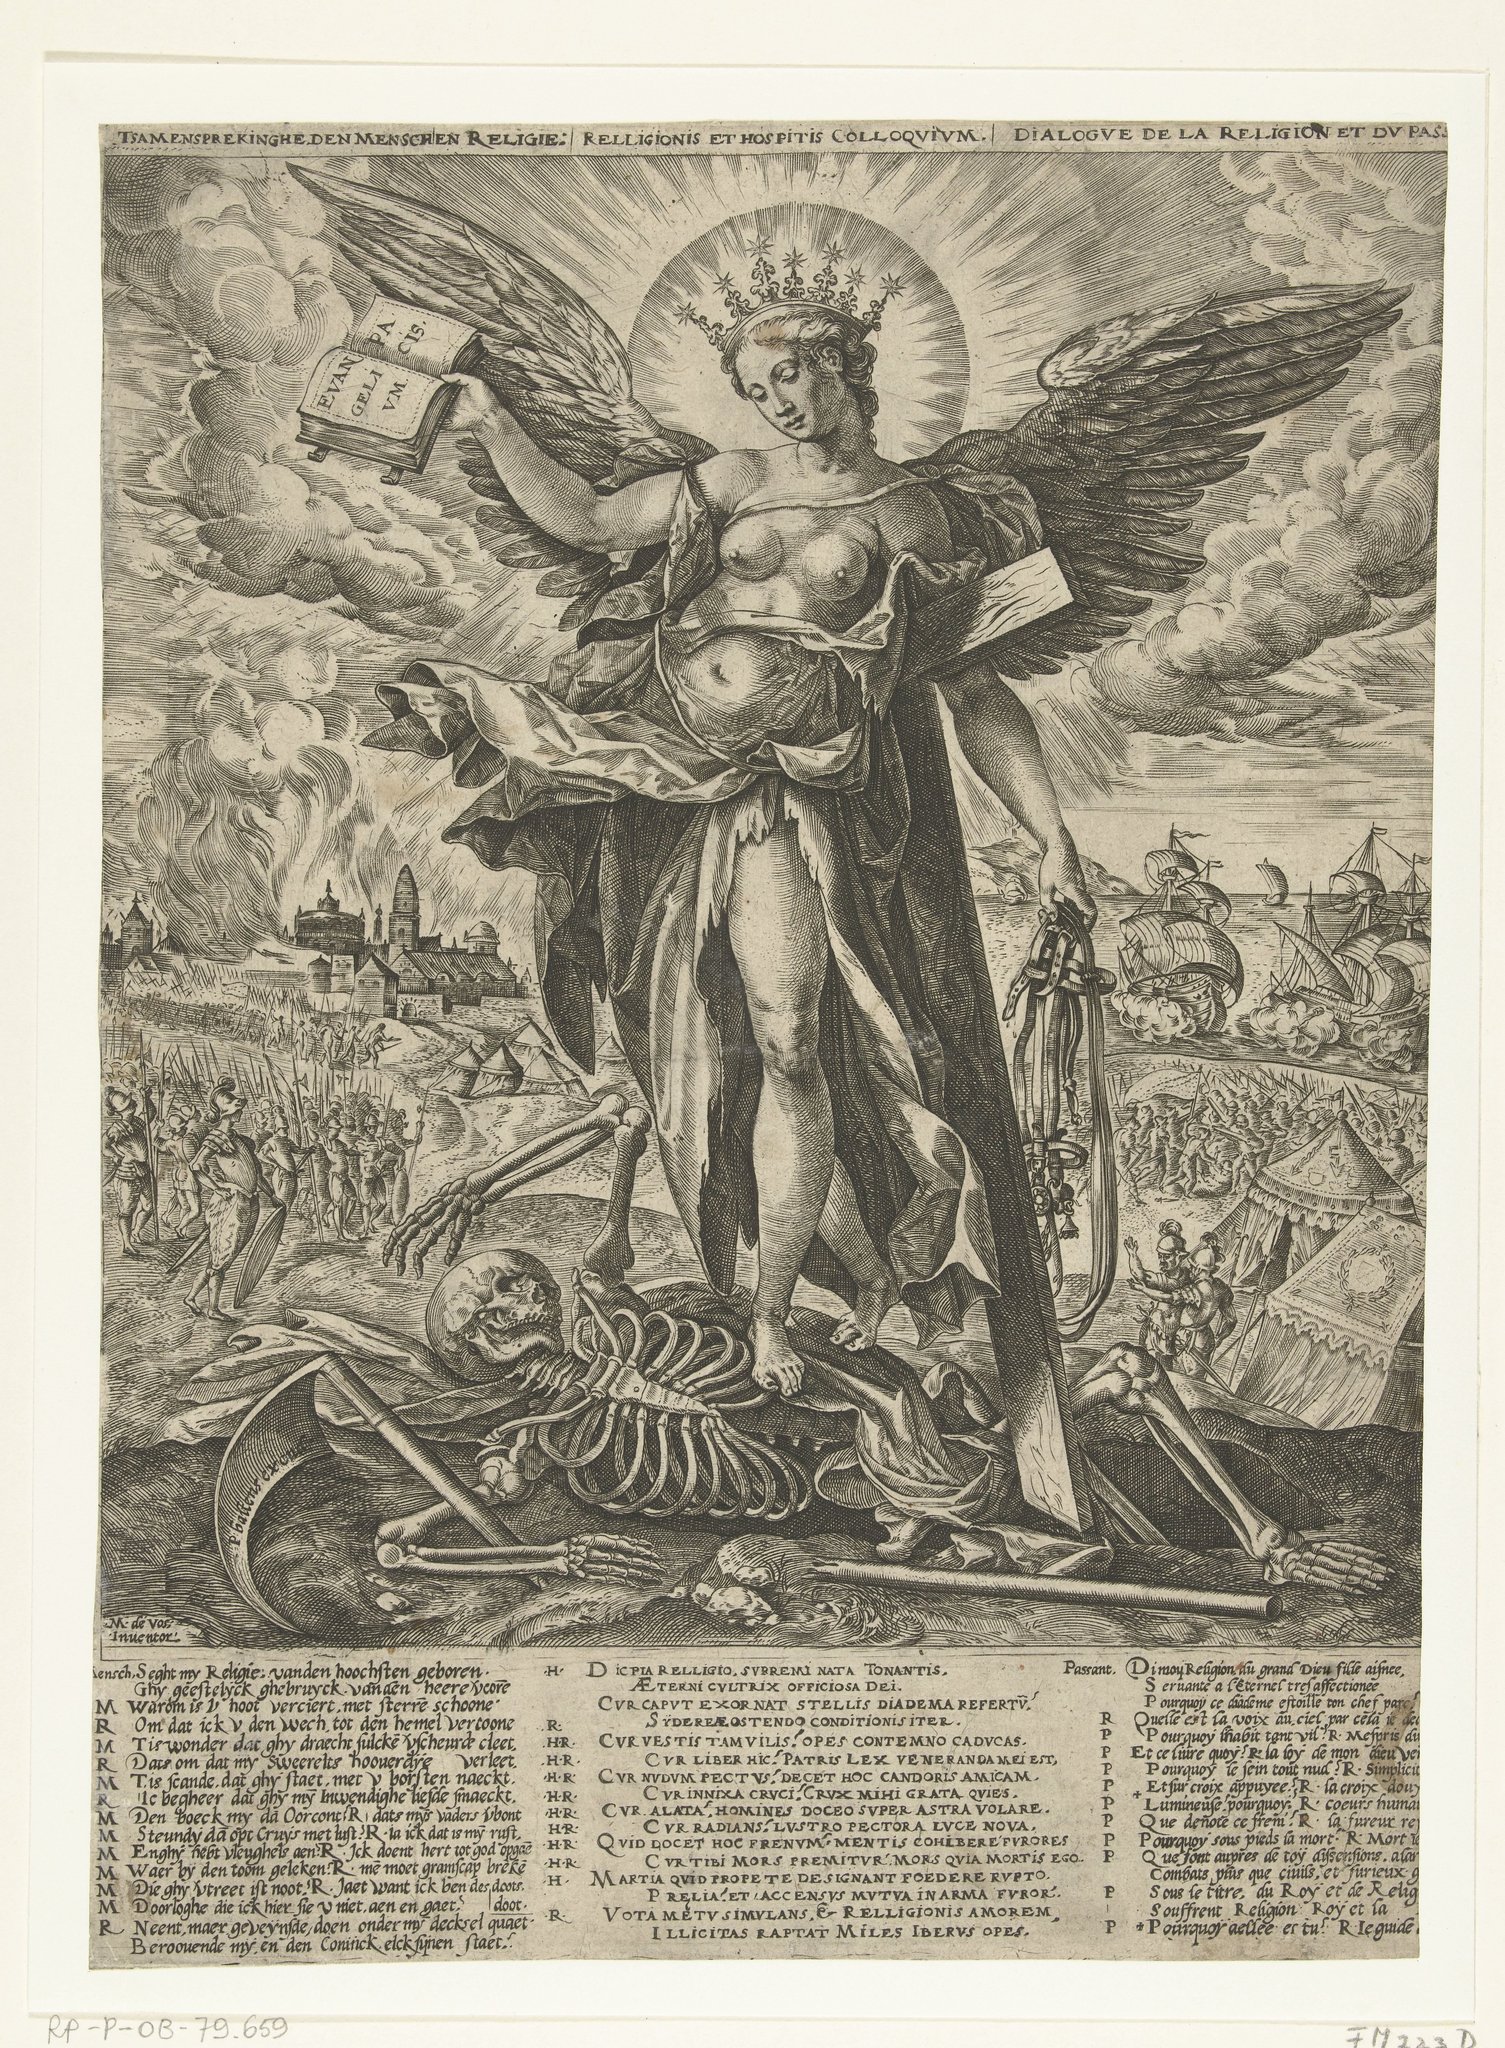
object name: propagandaprent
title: Relligionis et hospitis colloquium / Dialogue de la religion en du passant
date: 1577-1579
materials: paper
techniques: engraving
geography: southern netherlands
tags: death as skeleton, allegorical representations ~ religion; 'religione', 'religione de ss. mauritio e lazaro', 'religione vera christiana' (ripa)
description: Gevleugelde stralende personificatie van Religie vertreedt de Dood in de vorm van een geraamte met zeis en met een been in het graf. Religie leunt op een houten kruis en houdt in een hand een opengeslagen boek aangeduid als het evangelie van de vrede, in de andere hand toom of teugels. Tegen een landschap geteisterd door oorlog. In het onderschrift een samenspraak in de vorm van vraag en antwoord tussen de Mens en Religie, in 3 kolommen in het Nederlands, Latijn en Frans.